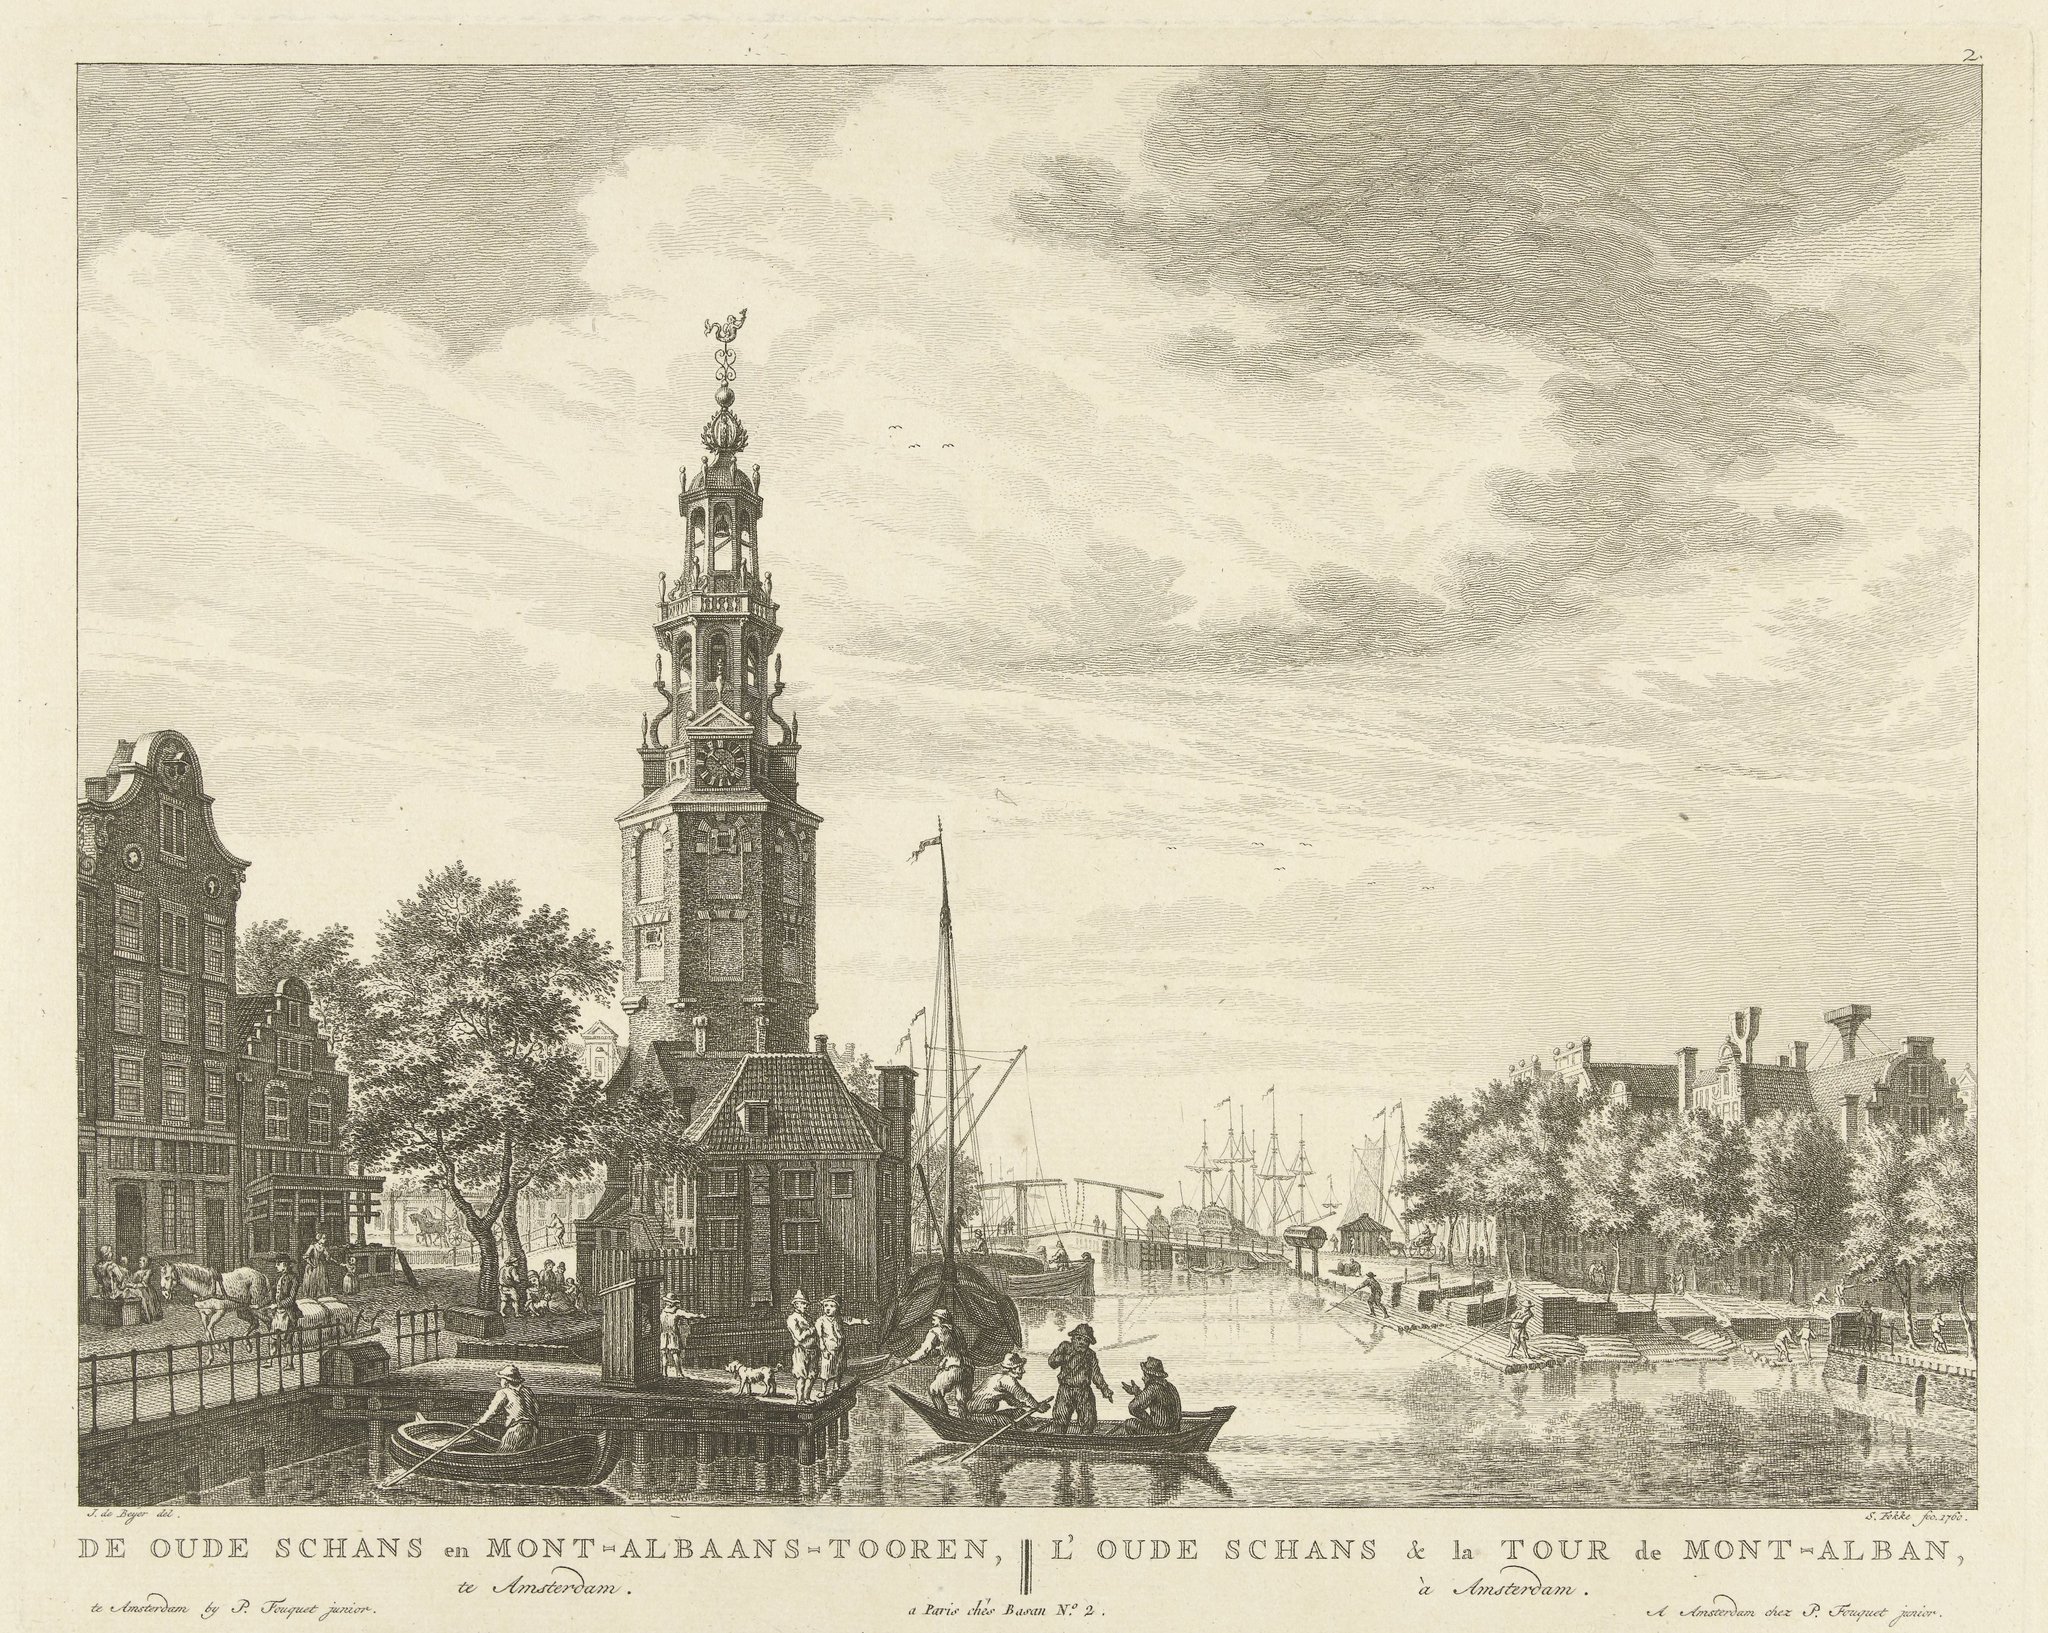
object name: print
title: Gezicht op de Oudeschans en Montelbaanstoren te Amsterdam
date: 1760-1801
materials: paper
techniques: engraving, etching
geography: paris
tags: bridge in city across river, canal, etc. (+ city(-scape) with figures, staffage), tower, clock tower ~ monumental adornment, towers ~ fortified city, canals, waters (in city) (+ city(-scape) with figures, staffage), street (+ city(-scape) with figures, staffage)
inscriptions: collector's mark: Lugt 2228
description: Deze prent is ook gebruikt in de zogenaamde Atlas van Fouquet.* Pierre Fouquet gaf vanaf 1760 stadsgezichten van Amsterdam - naar tekeningen van verschillende kunstenaars, gemaakt door verschillende prentmakers - uit. Deze prenten werden aanvankelijk los of in series verkocht. Zoals toen gebruikelijk kon de koper de prenten zelf laten inbinden. Hiertoe gaf Fouquet tussen 1778 en 1783 een titelblad, plattegrond en inhoudsopgave van de tot dusver 100 uitgegeven prenten uit (1). Gezien de inhoud afhankelijk was van wat de koper had verzameld verschilt de inhoud van de verschillende bewaarde Fouquetatlassen onder deze titel sterk. Ook zijn er exemplaren bekend waar tevens andere prenten aan zijn toegevoegd. Omdat er behoefte bleek aan uitleg bij de platen werd in 1783 een nieuwe versie van de atlas uitgegeven, aangevuld met tekst en twee prenten. De aangegeven volgorde veranderde maar de platen van de al eerder uitgegeven prenten bleven ongewijzigd. Deze uitgave werd in opdracht van Fouquet gedrukt bij Daniël Jean Changuion en Petrus den Hengst (2). Een tiental platen werd bijgewerkt en verscheen, met nieuw impressum, in het vervolg van Wagenaars geschiedenis van Amsterdam, uitgeven door Petrus Conradi en Folkert van der Plaats (3). Een aantal jaar na het overlijden van Fouquet kwam Evert Maaskamp met een nieuwe uitgave van de atlas, met verbeterde tekst en toevoeging van twee prenten. Op alle platen verwijderde hij het oude en liet hij zijn eigen impressum zetten (4). De huidige staat van de prent komt voor in exemplaren van de onder (1) en (2) genoemde werken. * Onder de Atlas van Fouquet of Fouquetatlas verstaan we de hieronder vermelde publicaties (1), (2) en (4). (1). Afbeeldingen van de wyd-vermaarde koopstad Amsterdam benevens des zelvs voornaamste gebouwen en gezigten alle naar het leeven getekend / Receuil des edifices les plus considerables et des plus belles vues, de la fameuse ville d'Amsterdam, dessinées d'après nature. Amsterdam: Pierre Fouquet, 1778-1783. (2). Nieuwe atlas, van de voornaamste gebouwen en gezigten der stad Amsterdam, met derzelver beknopte beschryvingen. 2 delen. Amsterdam: Daniël Jean Changuion en Petrus den Hengst [in opdracht van Pierre Fouquet], 1783. (3). Stijl, Simon. Amsterdam, in zyne geschiedenissen, voorregten, koophandel, gebouwen, kerkenstaat, schoolen, schutterye, gilden en regeeringe, beschreeven. Om te dienen ten vervolge op het werk van Jan Wagenaar (…). 10 delen. Amsterdam en Harlingen: Petrus Conradi en Folkert van der Plaats, 1788-1801. (4). Nieuwe atlas, van de voornaamste gebouwen en gezigten der stad Amsterdam. Met derzelver beknopte beschryvingen. Amsterdam: Evert Maaskamp, 1805. * Het aantal vermelde staten is gebaseerd op het aantal gevonden staten. Mogelijk zijn er meer staten van deze prent. Vermoedelijke eerste staat in collectie van TU Delft met Paulus van Liender vermeld als prentmaker. Vermoedelijke tweede staat, zie RP-P-1921-301 en KOG-AA-1-13-6. Vermoedelijke derde staat, zie KOG-AA-1-13-5. Vermoedelijke vijfde staat, zie KOG-AA-1-29-68. Vermoedelijke laatste staat met adres van Maaskamp.